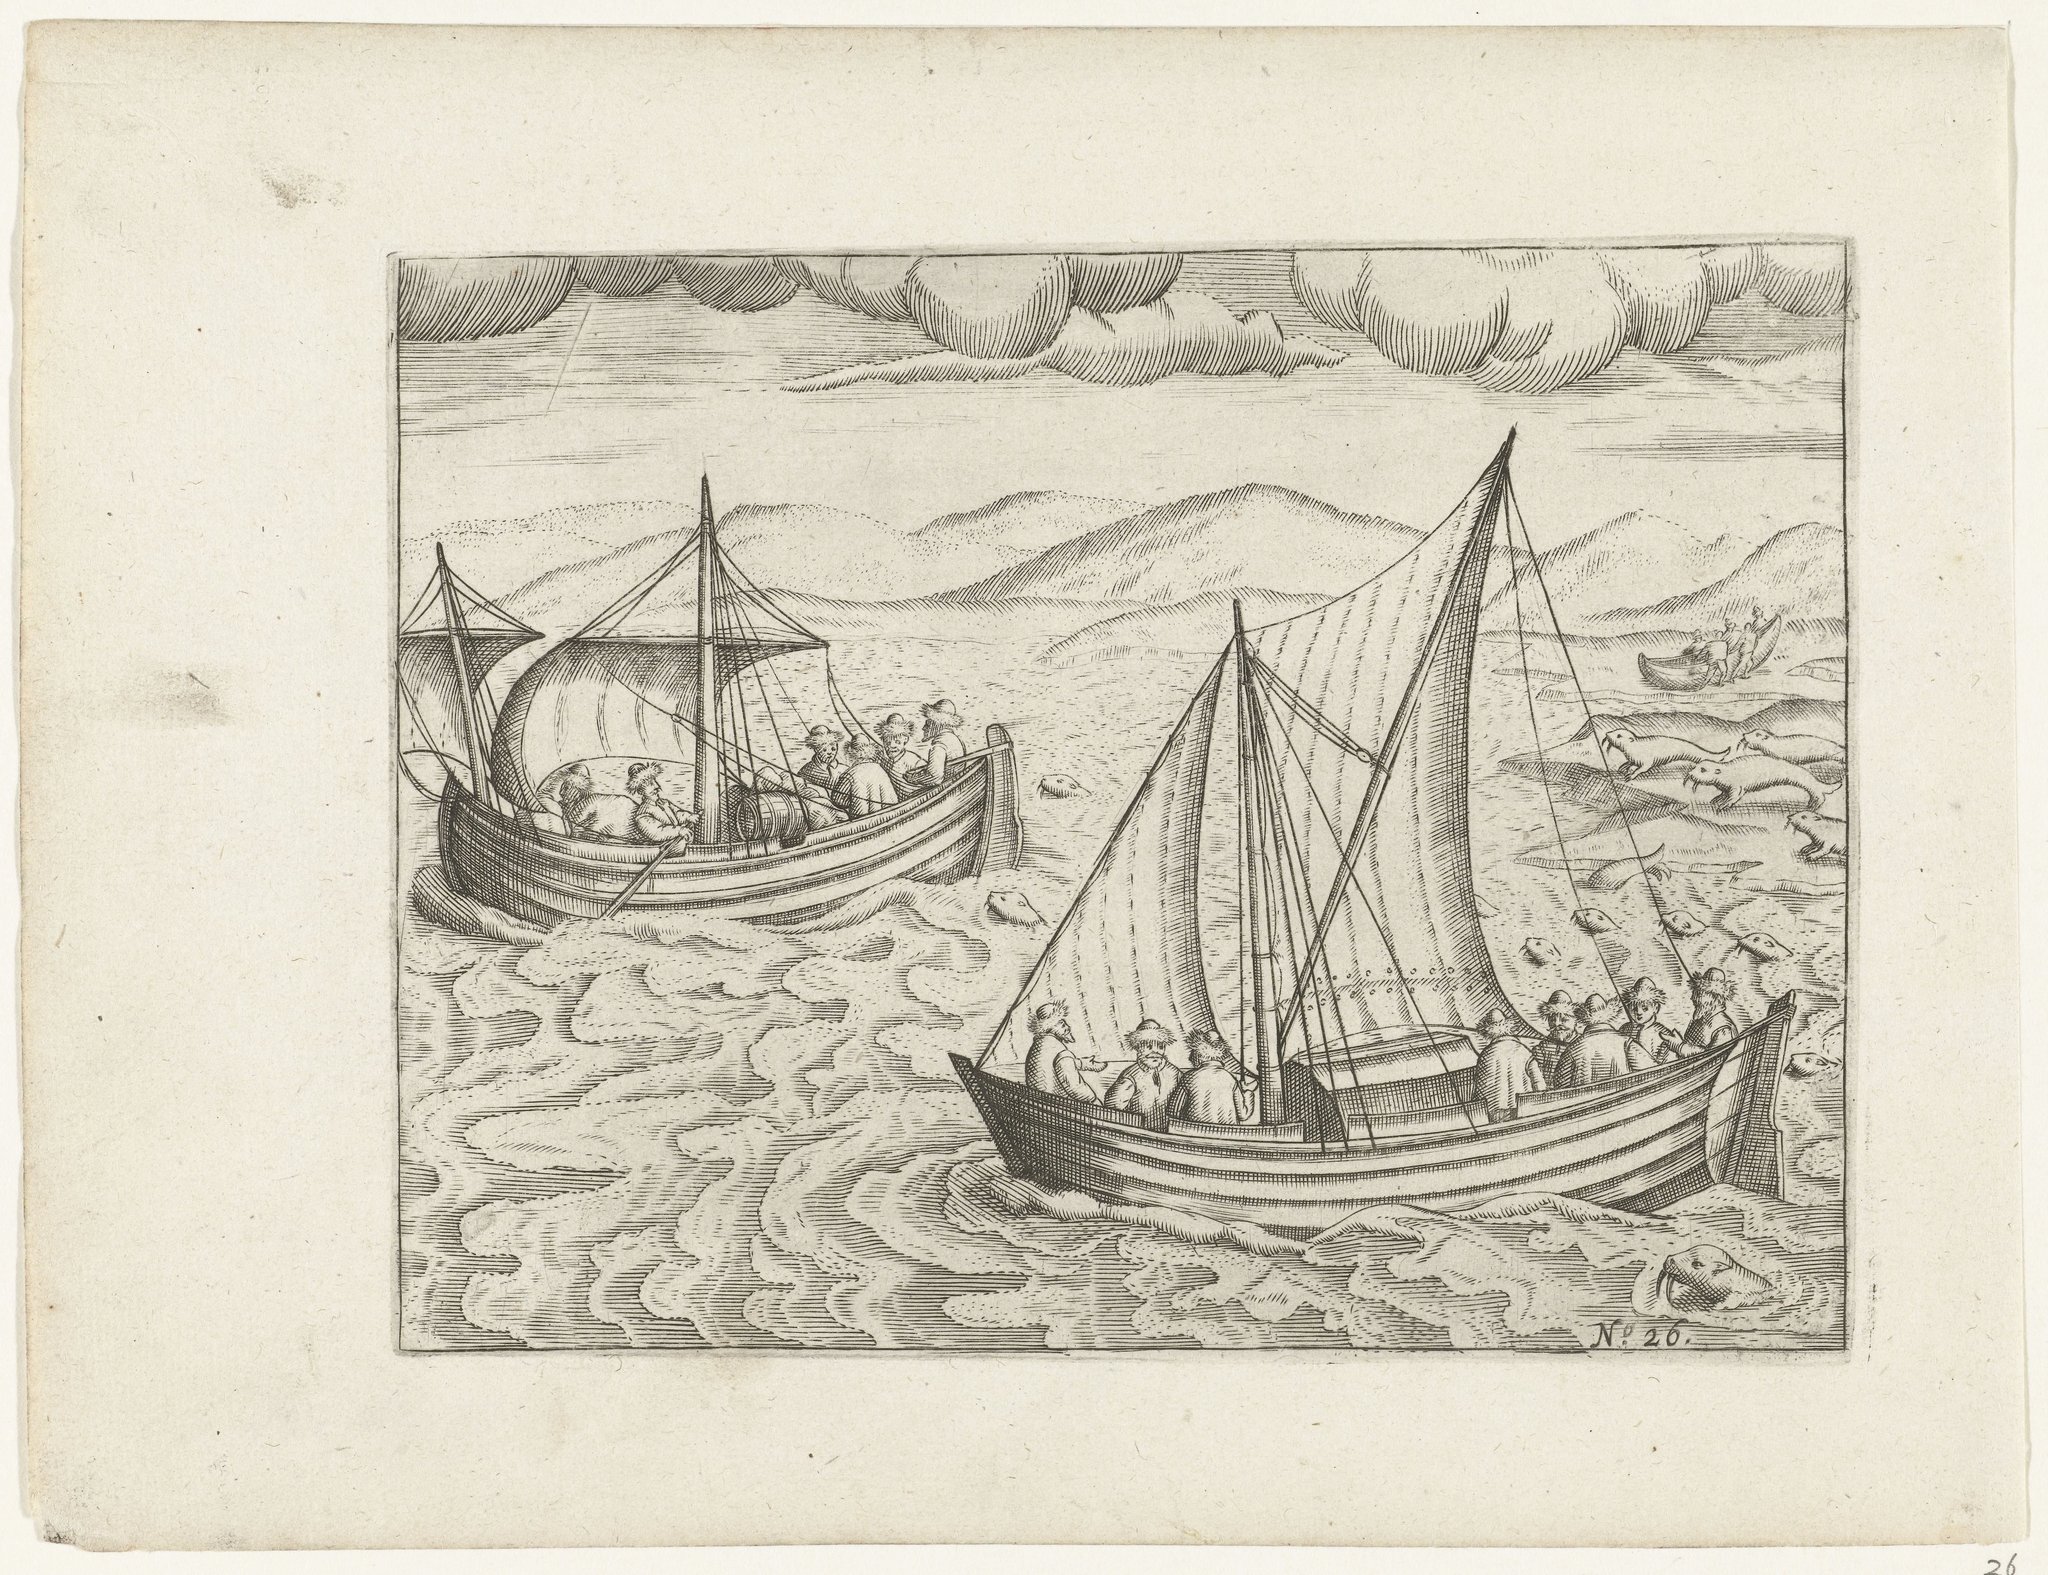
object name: history print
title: Het vertrek van het eiland, 1597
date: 1615-1617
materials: paper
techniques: engraving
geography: northern netherlands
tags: willem barendsz., amsterdam, jacob van heemskerck, landscapes in polar regions, exploration, expedition, voyage of discovery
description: Gebruikt als illustratie eerst in: G. de Veer, De waerachtige beschrijvinge vande drie seylagien, drie jaren achter mal-kanderen deur de Hollandtsche ende Zeelandtsche Schepen, by noorden Noorweghen, Moscovien ende tartarien nae de Coninckrijcken van Catthay ende China ghedaene, [Michiel Colijn, Amsterdam 1617]. Later gebruikt in: Kort verhael van d'eerste Schipvaerd der Hollandsche ende Zeeusche Schepen by noorden Noorwegen, Moscovien ende Tartarien om, nae de Coningrijcken van Cathay ende China, getogen uyt het Journael van Gerrit de Veer. Opgenomen in: I. Commelin, Begin ende voortgangh, van de Vereenighde Nederlantsche Geoctroyeerde Oost-Indische Compagnie, J. Janssonius, Amsterdam 1646. Genummerd: No. 26.